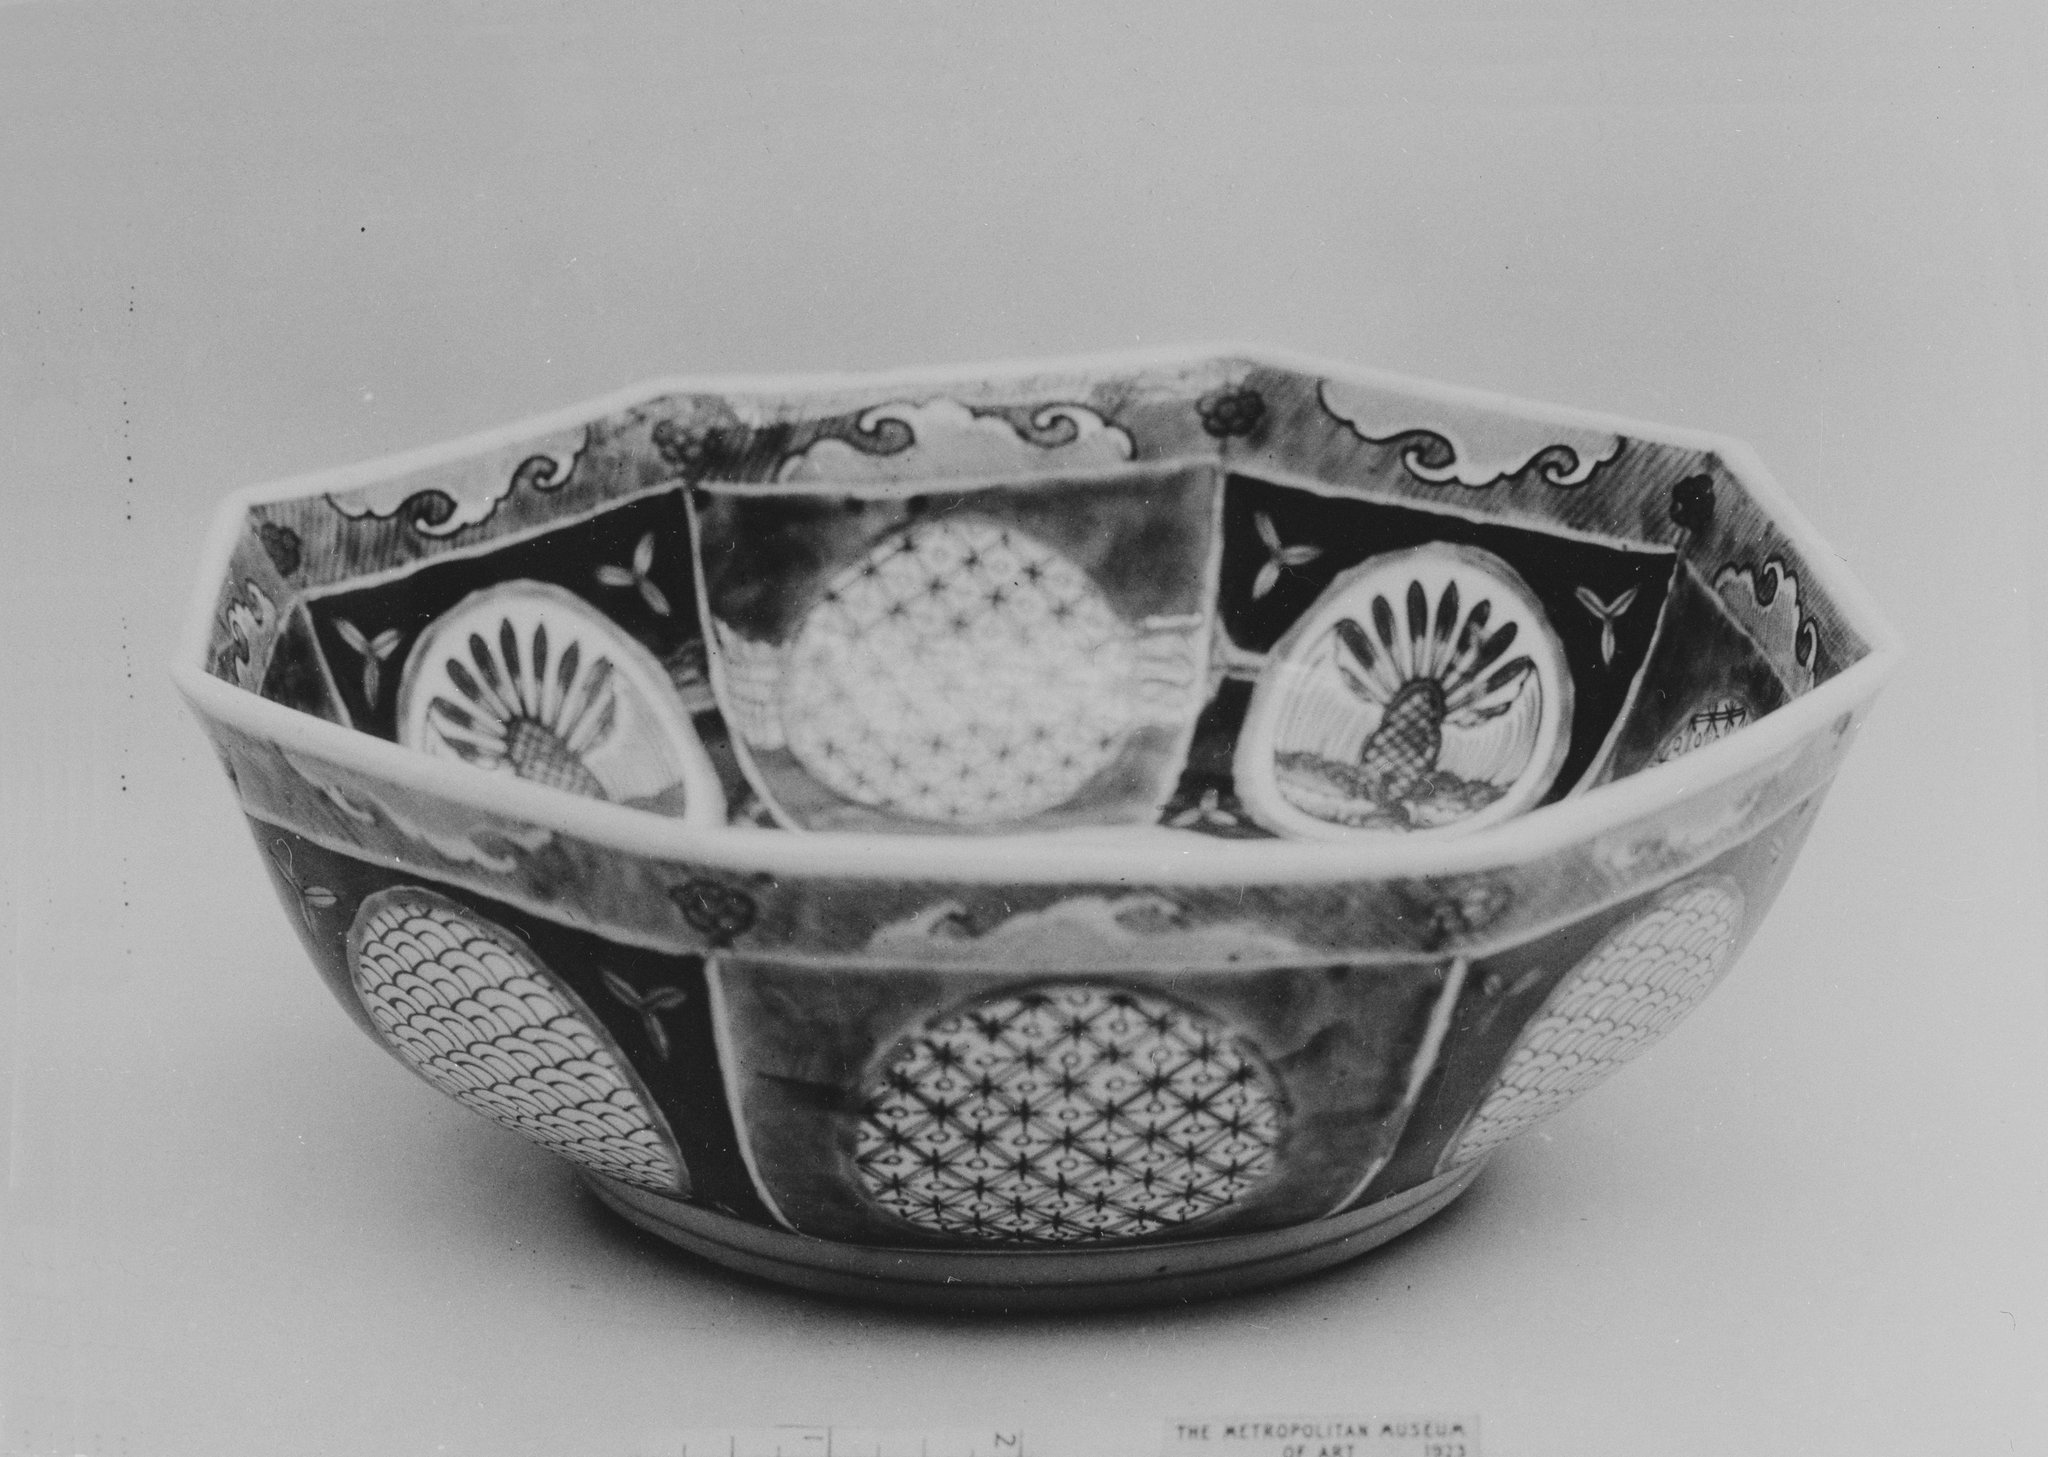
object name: bowl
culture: japanese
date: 1780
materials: enamel, porcelain